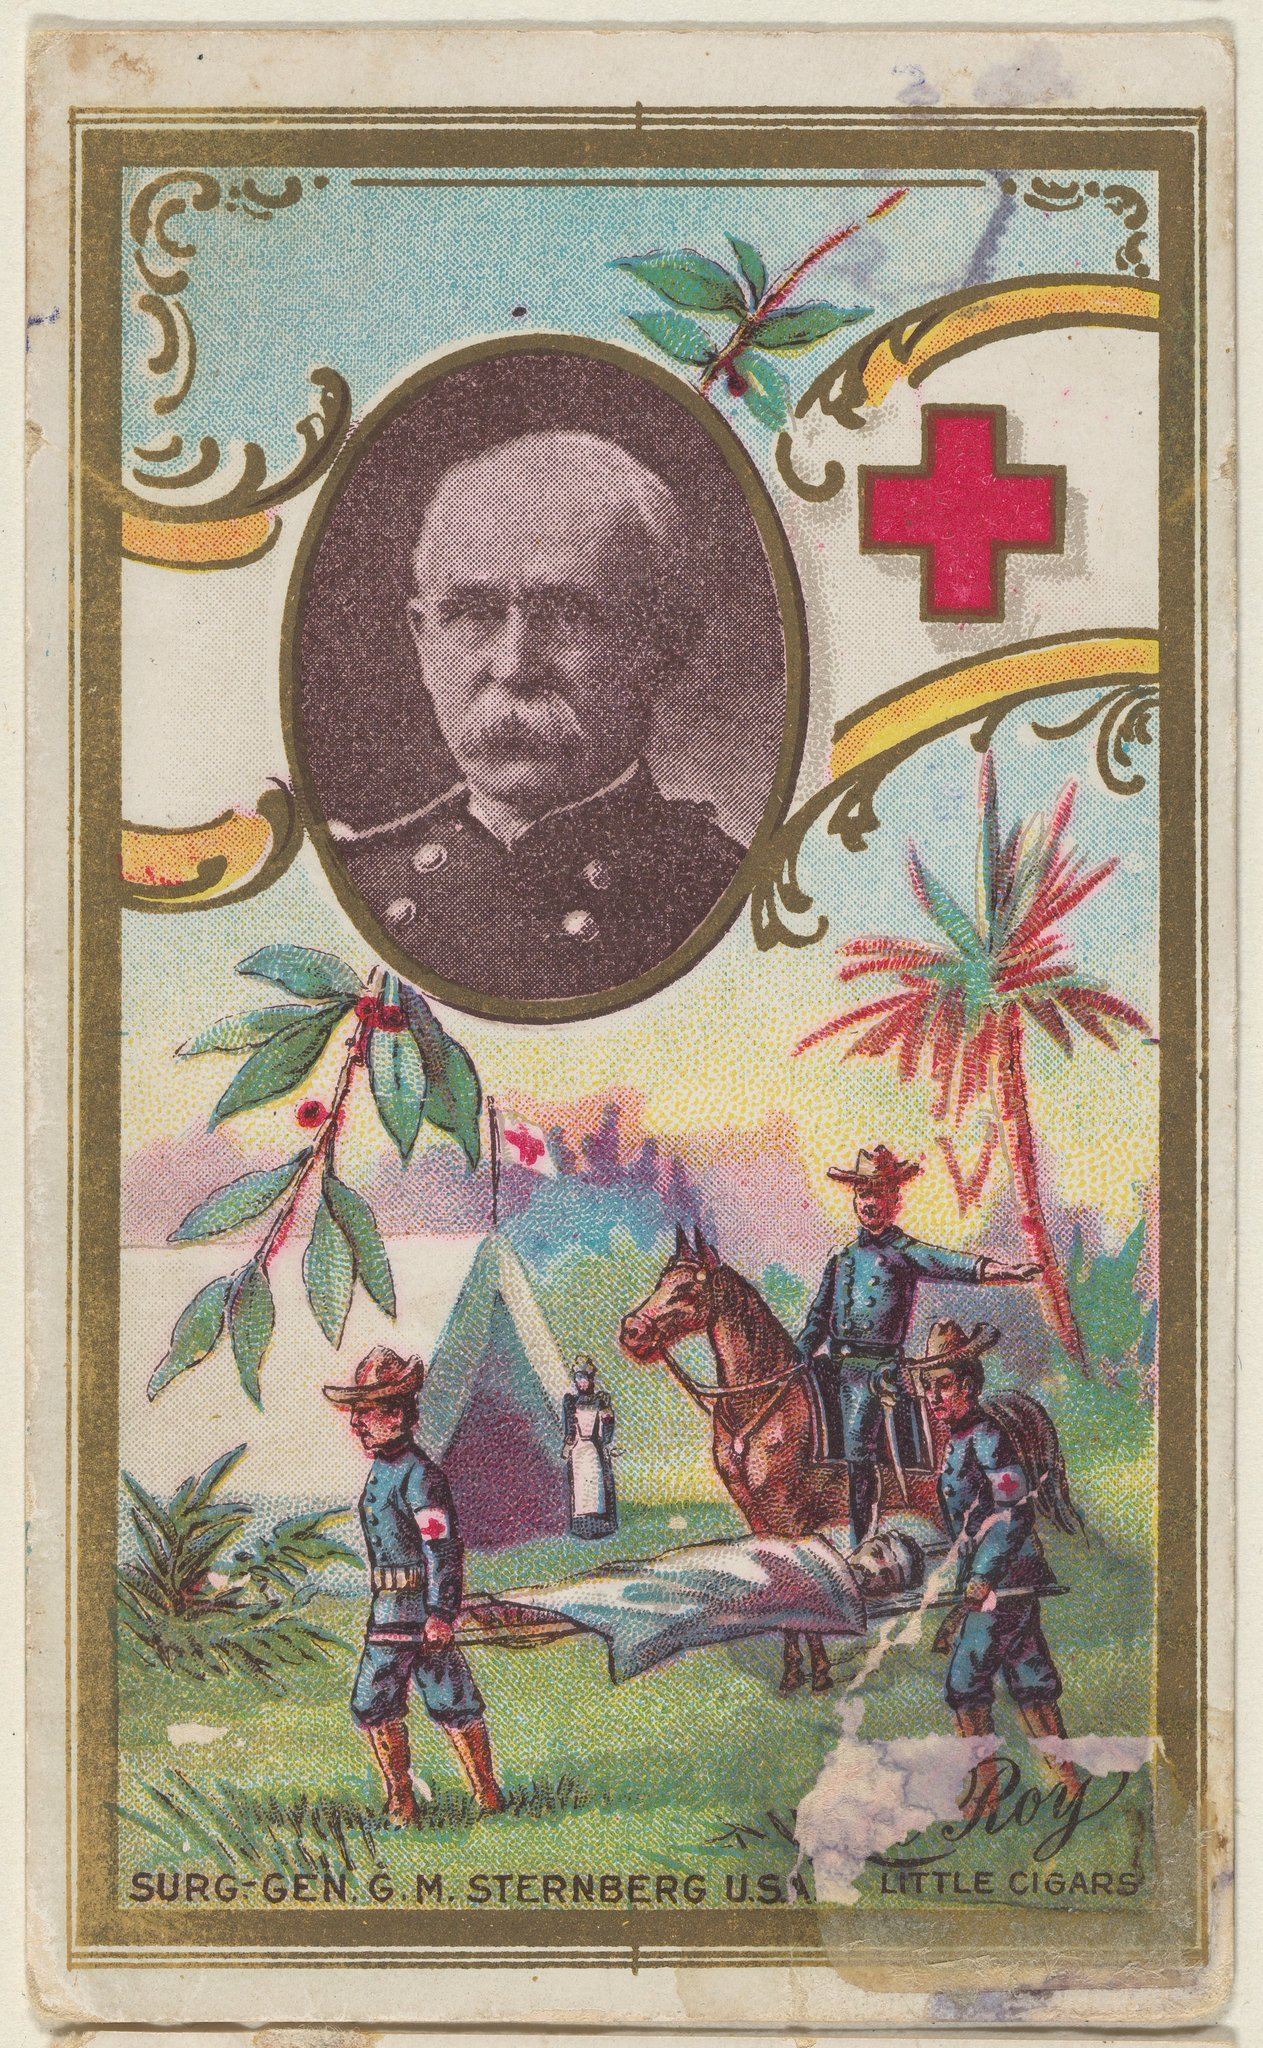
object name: print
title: Surgeon General George M. Sternberg, U.S. Army, from the "Generals" series (T63), issued by LeRoy Little Cigars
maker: leroy little cigars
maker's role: publisher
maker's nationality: american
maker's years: 1850-1950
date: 1898-1901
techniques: color lithograph